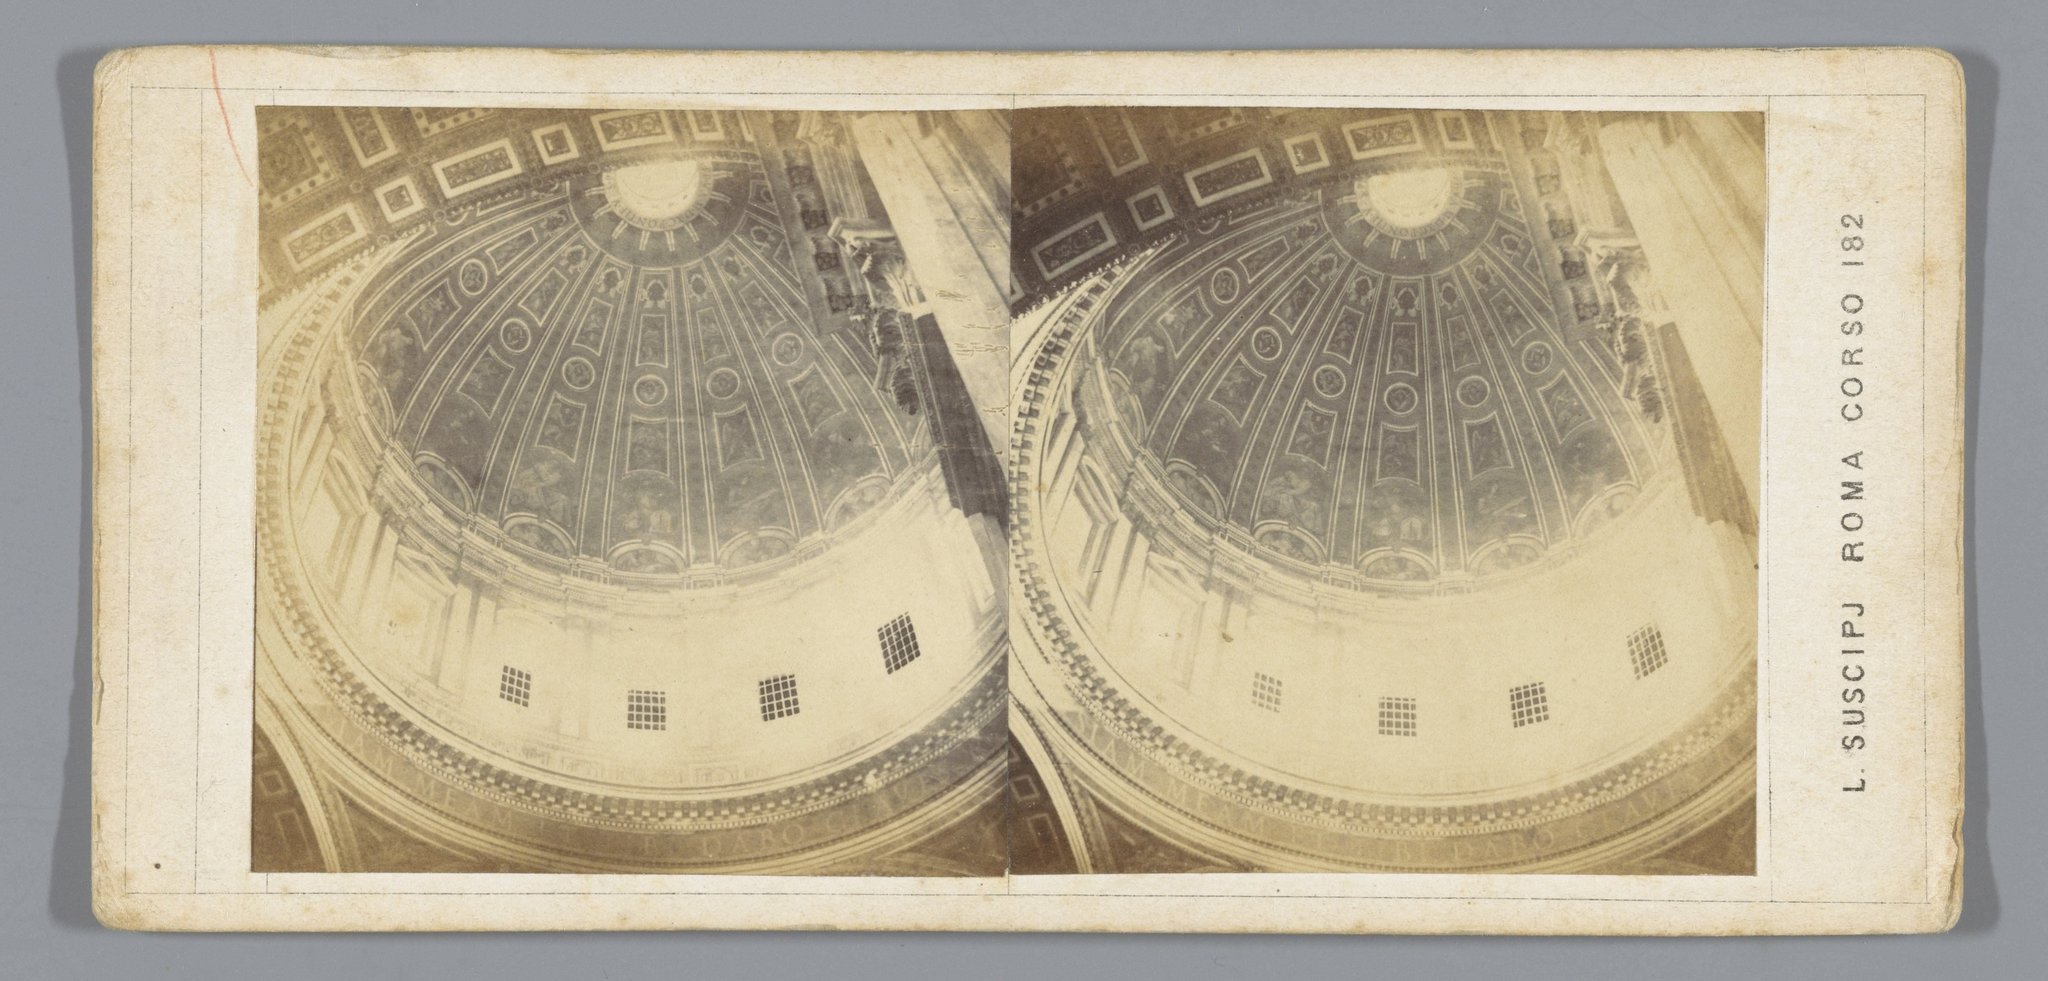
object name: stereograph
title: Interieur van de koepel van de Sint-Pietersbasiliek in Vaticaanstad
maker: lorenzo suscipi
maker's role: fotograaf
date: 1850-1880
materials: cardboard, photographic support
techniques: albumen print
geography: sint-pietersbasiliek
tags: parts of church interior: dome